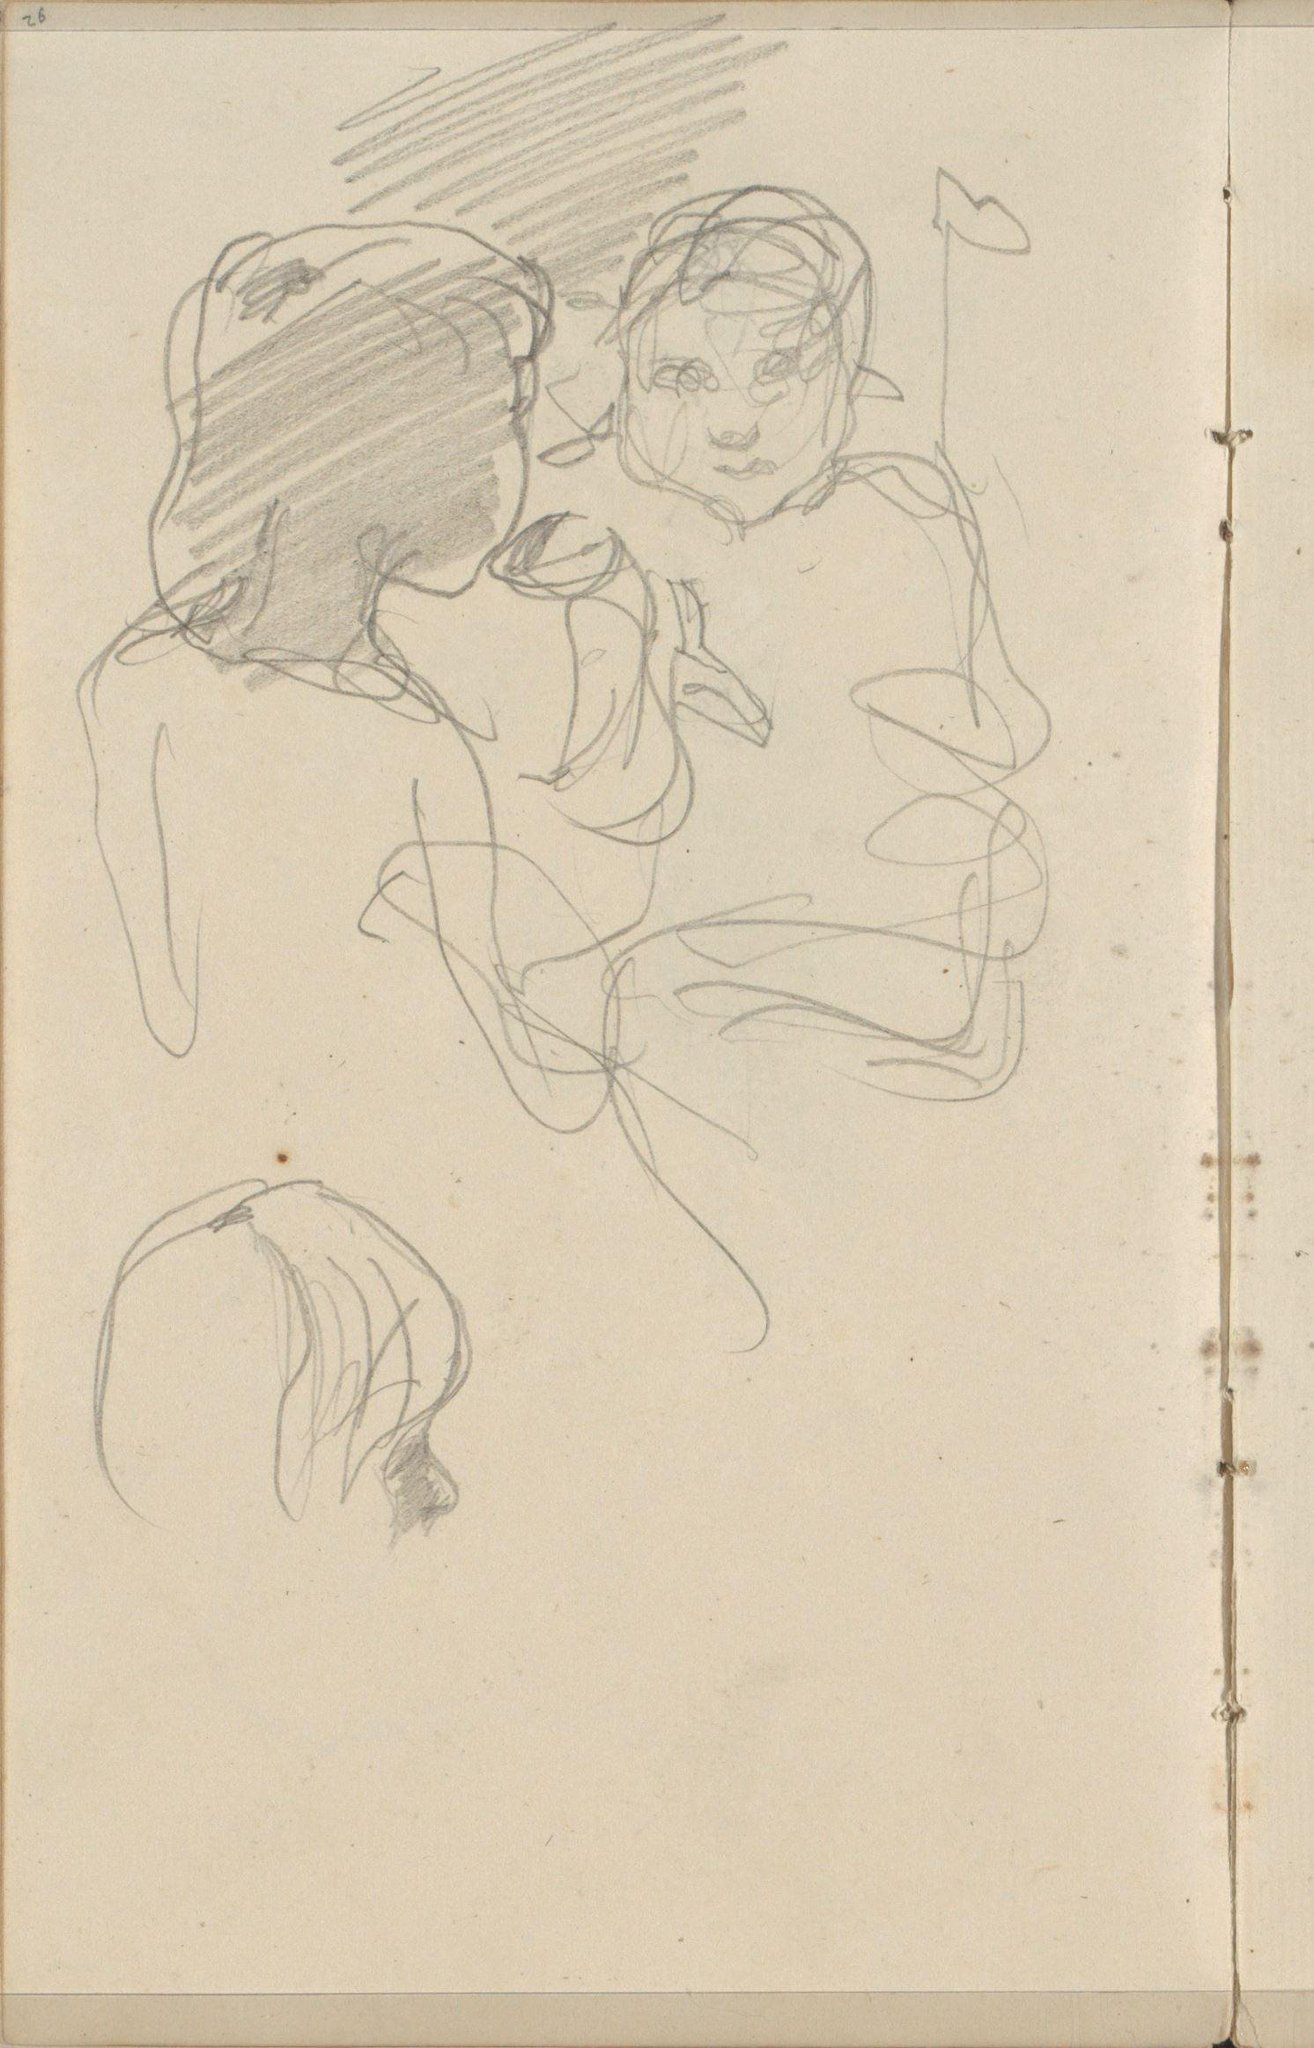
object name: sketchbook leaf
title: Twee jonge vrouwen tegenover elkaar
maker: george hendrik breitner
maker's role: draughtsman, painter, print maker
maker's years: 1857-1923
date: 1880-1882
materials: paper, pencil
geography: the hague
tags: adolescent, young woman, maiden (+ two persons)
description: Pagina 26 uit een schetsboek met 25 bladen.